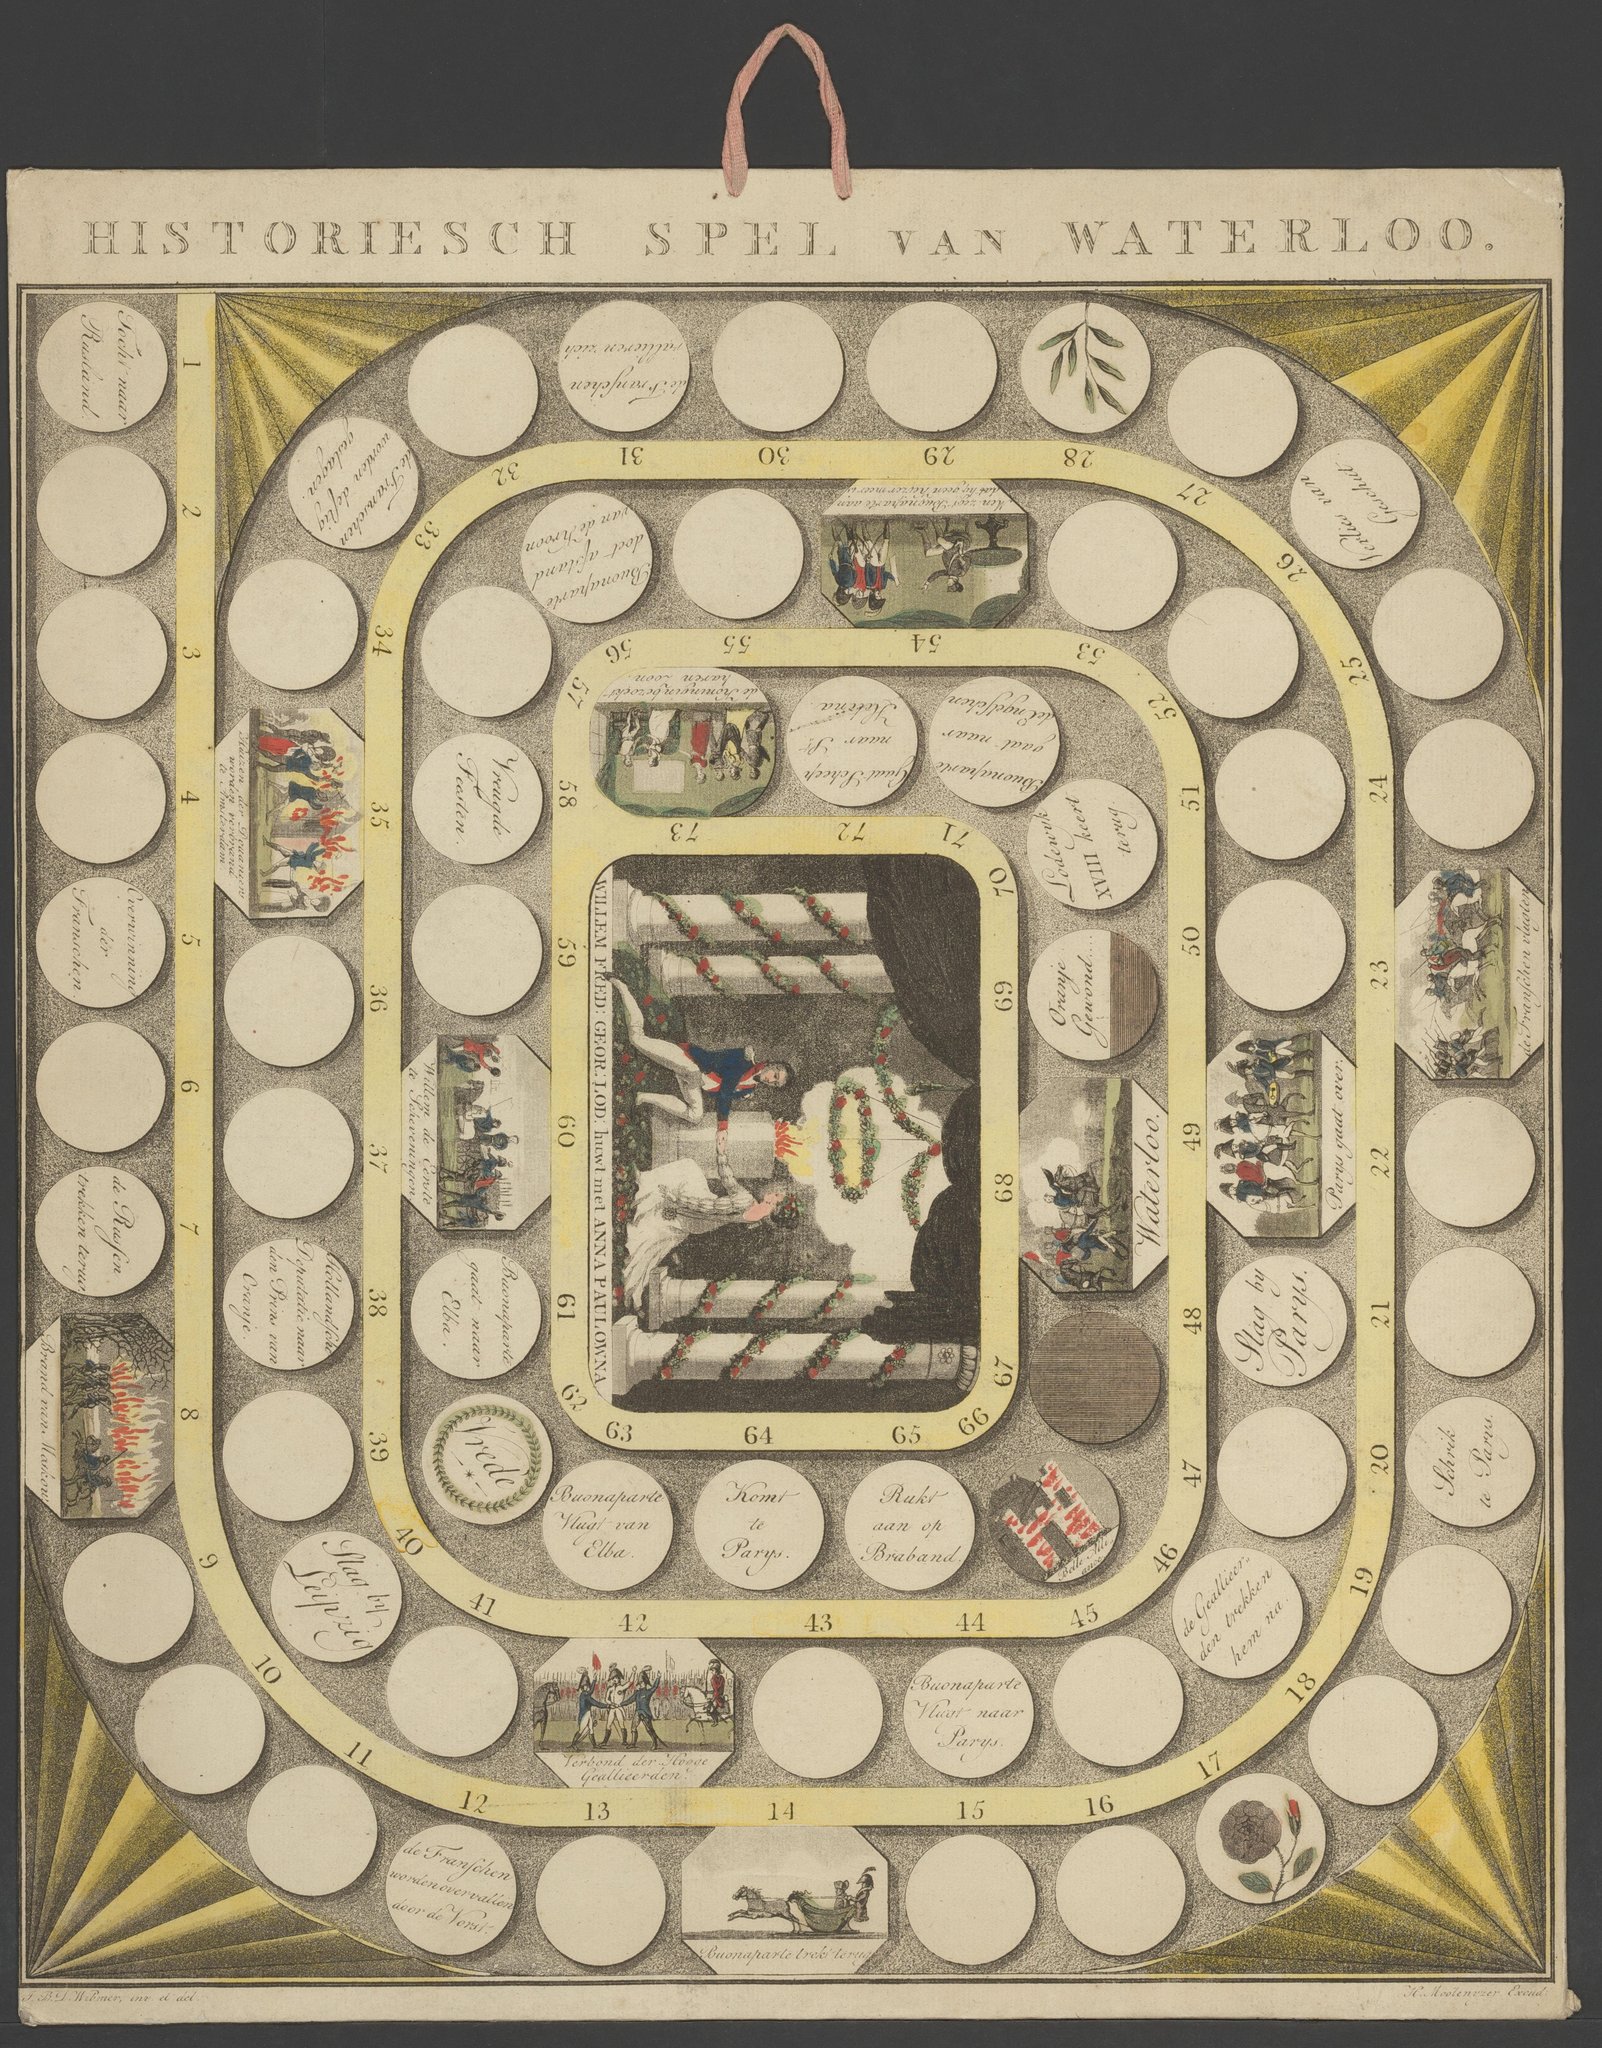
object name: print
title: Speelbord historisch spel van Waterloo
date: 1816-1817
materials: paper, ribbon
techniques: aquatint, engraving, hand coloring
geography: amsterdam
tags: anna paulowna romanowa, the hague, berlin, william i of the netherlands, william ii of the netherlands, napoleon i (emperor of the french), board-games of chance, board-games, waterloo, amsterdam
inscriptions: collector's mark: Lugt 1641, stamp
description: Bordspel in de vorm van een spiraal met vakken genummerd van 1 tot en met 73. Verschillende voorstellingen van historische gebeurtenissen van de tocht naar Rusland tot de slag bij Waterloo. Op het middenveld een voorstelling van het huwelijk van Willem II en Anna Paulowna Romanowa. Onderwerpsrubrieken binnen de Atlas Zeden en Gewoonten: Zeden en gewoonten in engeren zin, Spel en vermaak, Gezelschapsspel II, Ganzenbord en dergelijke.